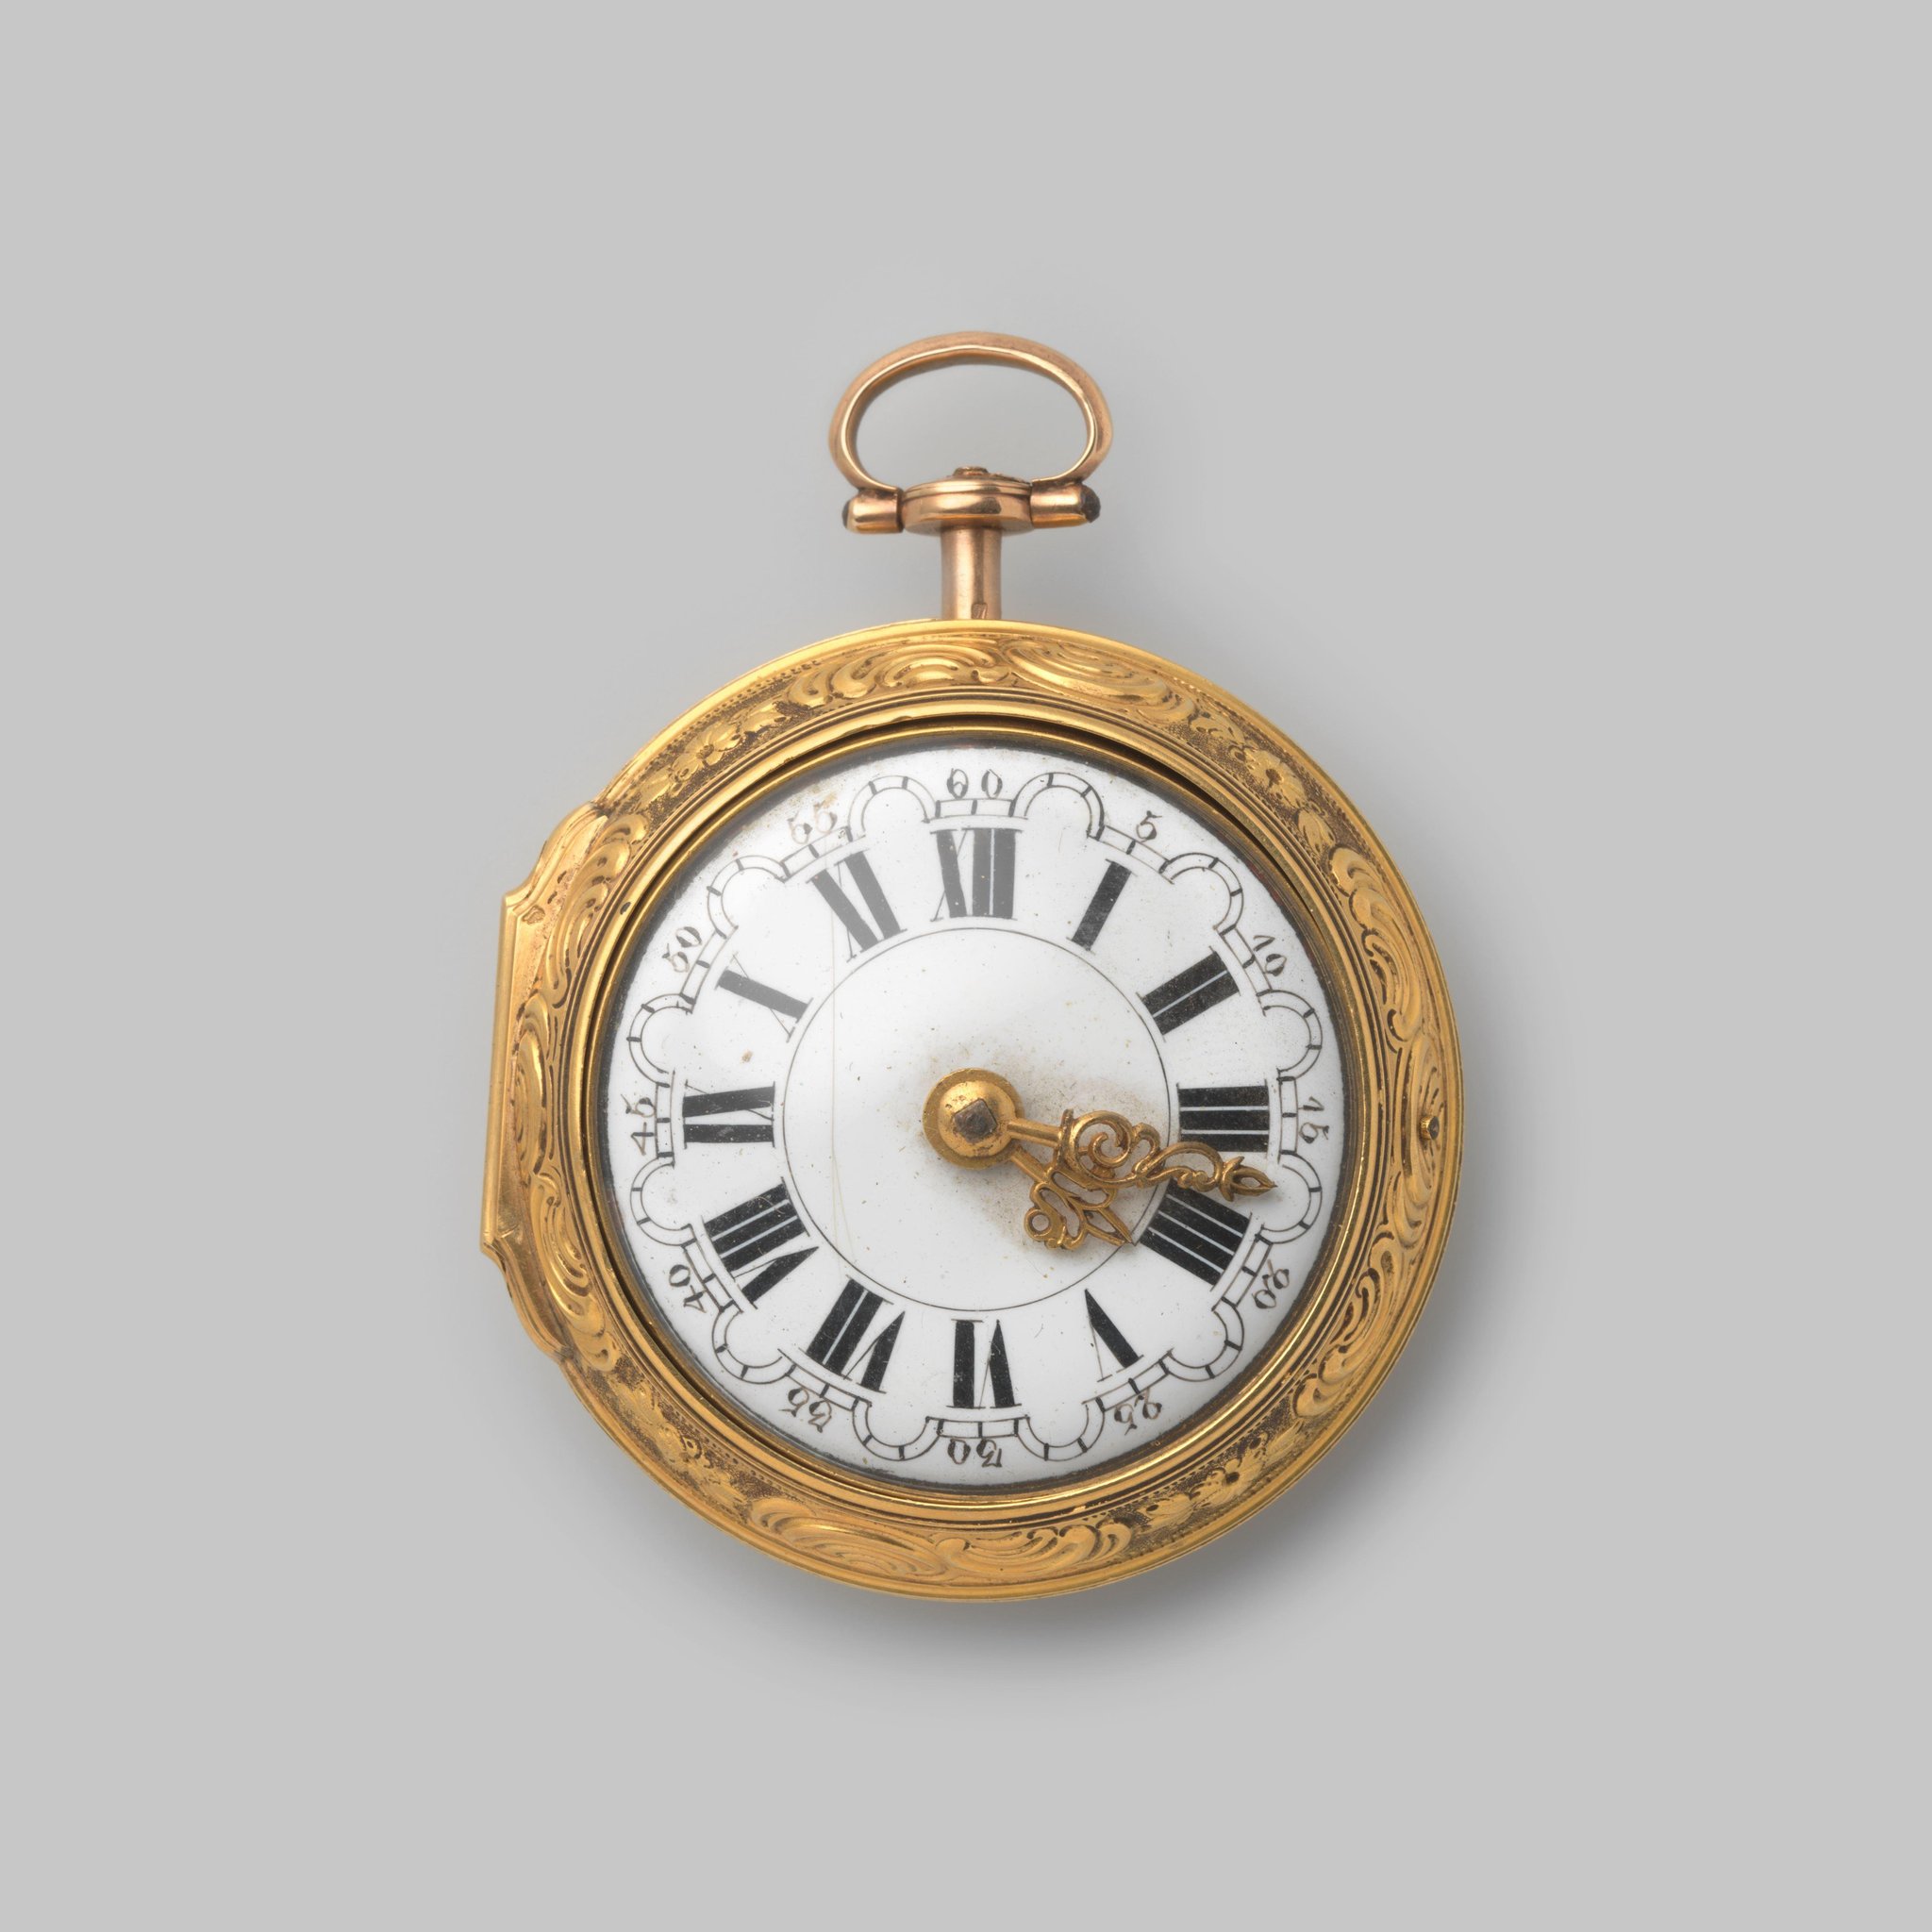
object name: wrist watch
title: Horloge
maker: john curtis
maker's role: clockmaker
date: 1786-1787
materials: gold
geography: london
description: Herenhorloge van goud met dubbele kast. De buitenkast vertoont een googgedreven reliëf voorstellende: Abigail, geschenken brengende aan David.